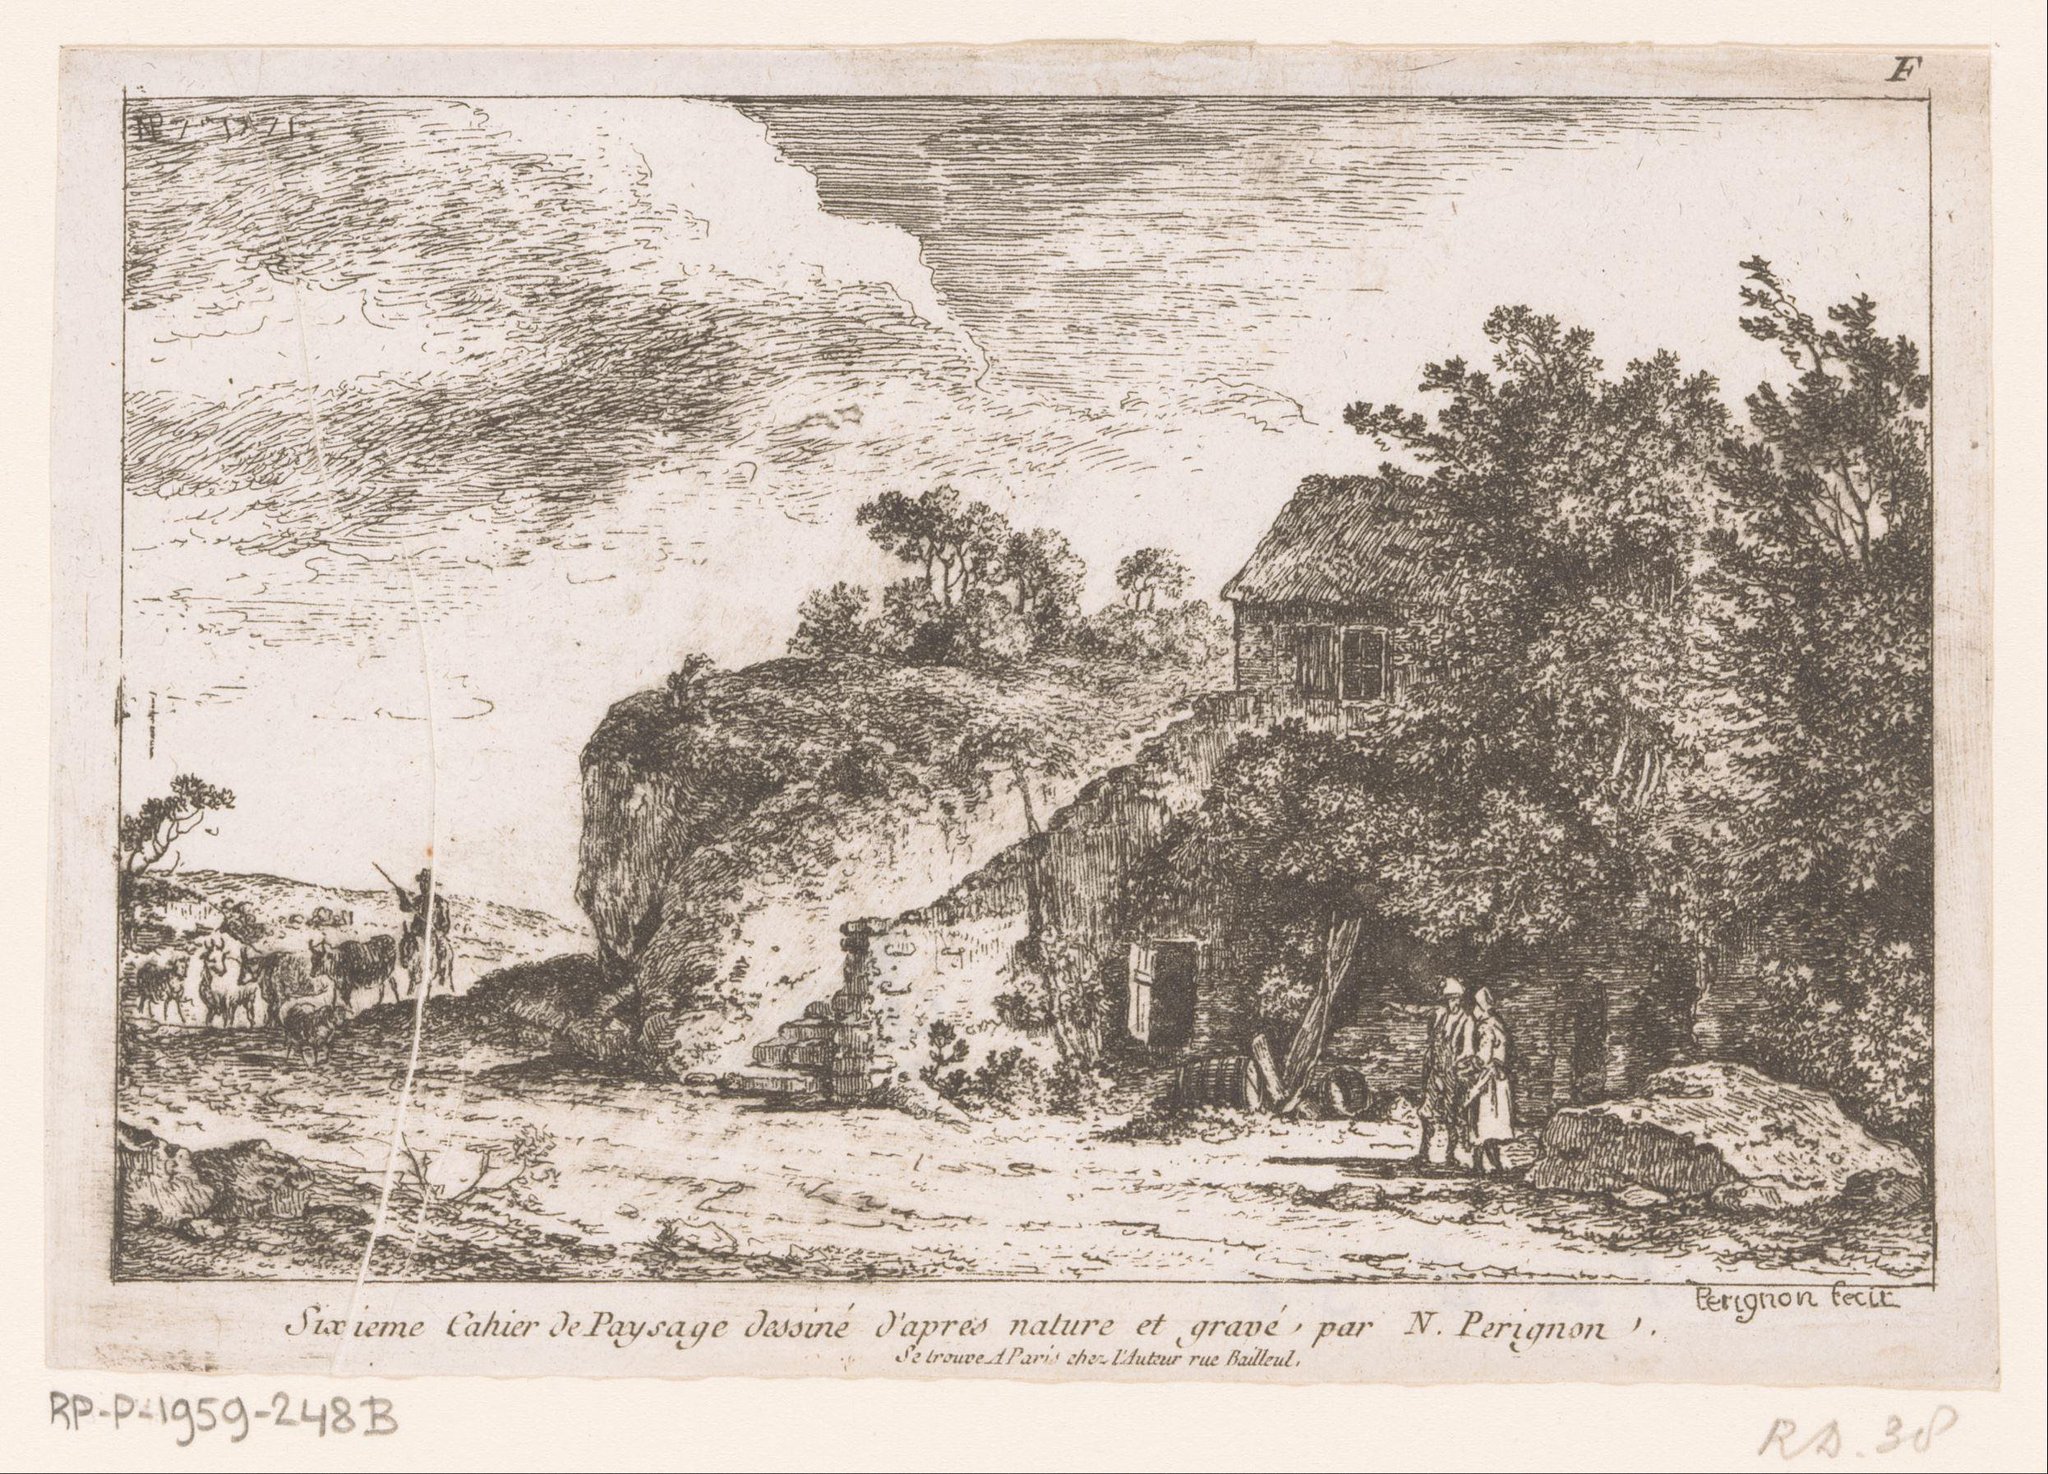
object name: print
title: Collectie landschappen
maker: alexis nicolas pérignon (le vieux)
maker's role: draughtsman, print maker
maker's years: 1726-1782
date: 1768-1772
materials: paper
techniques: etching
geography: paris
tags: herding, herdsman, herdswoman, shepherd, shepherdess, cowherd, etc., farm or solitary house in landscape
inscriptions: collector's mark: Lugt 2228, collector's mark: Lugt 2760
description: Tussen 1768 en 1772 publiceerde Pérignon zes Cahiers de Paysage, met elk zes prenten. Dit is de titelprent van het zesde Cahier.